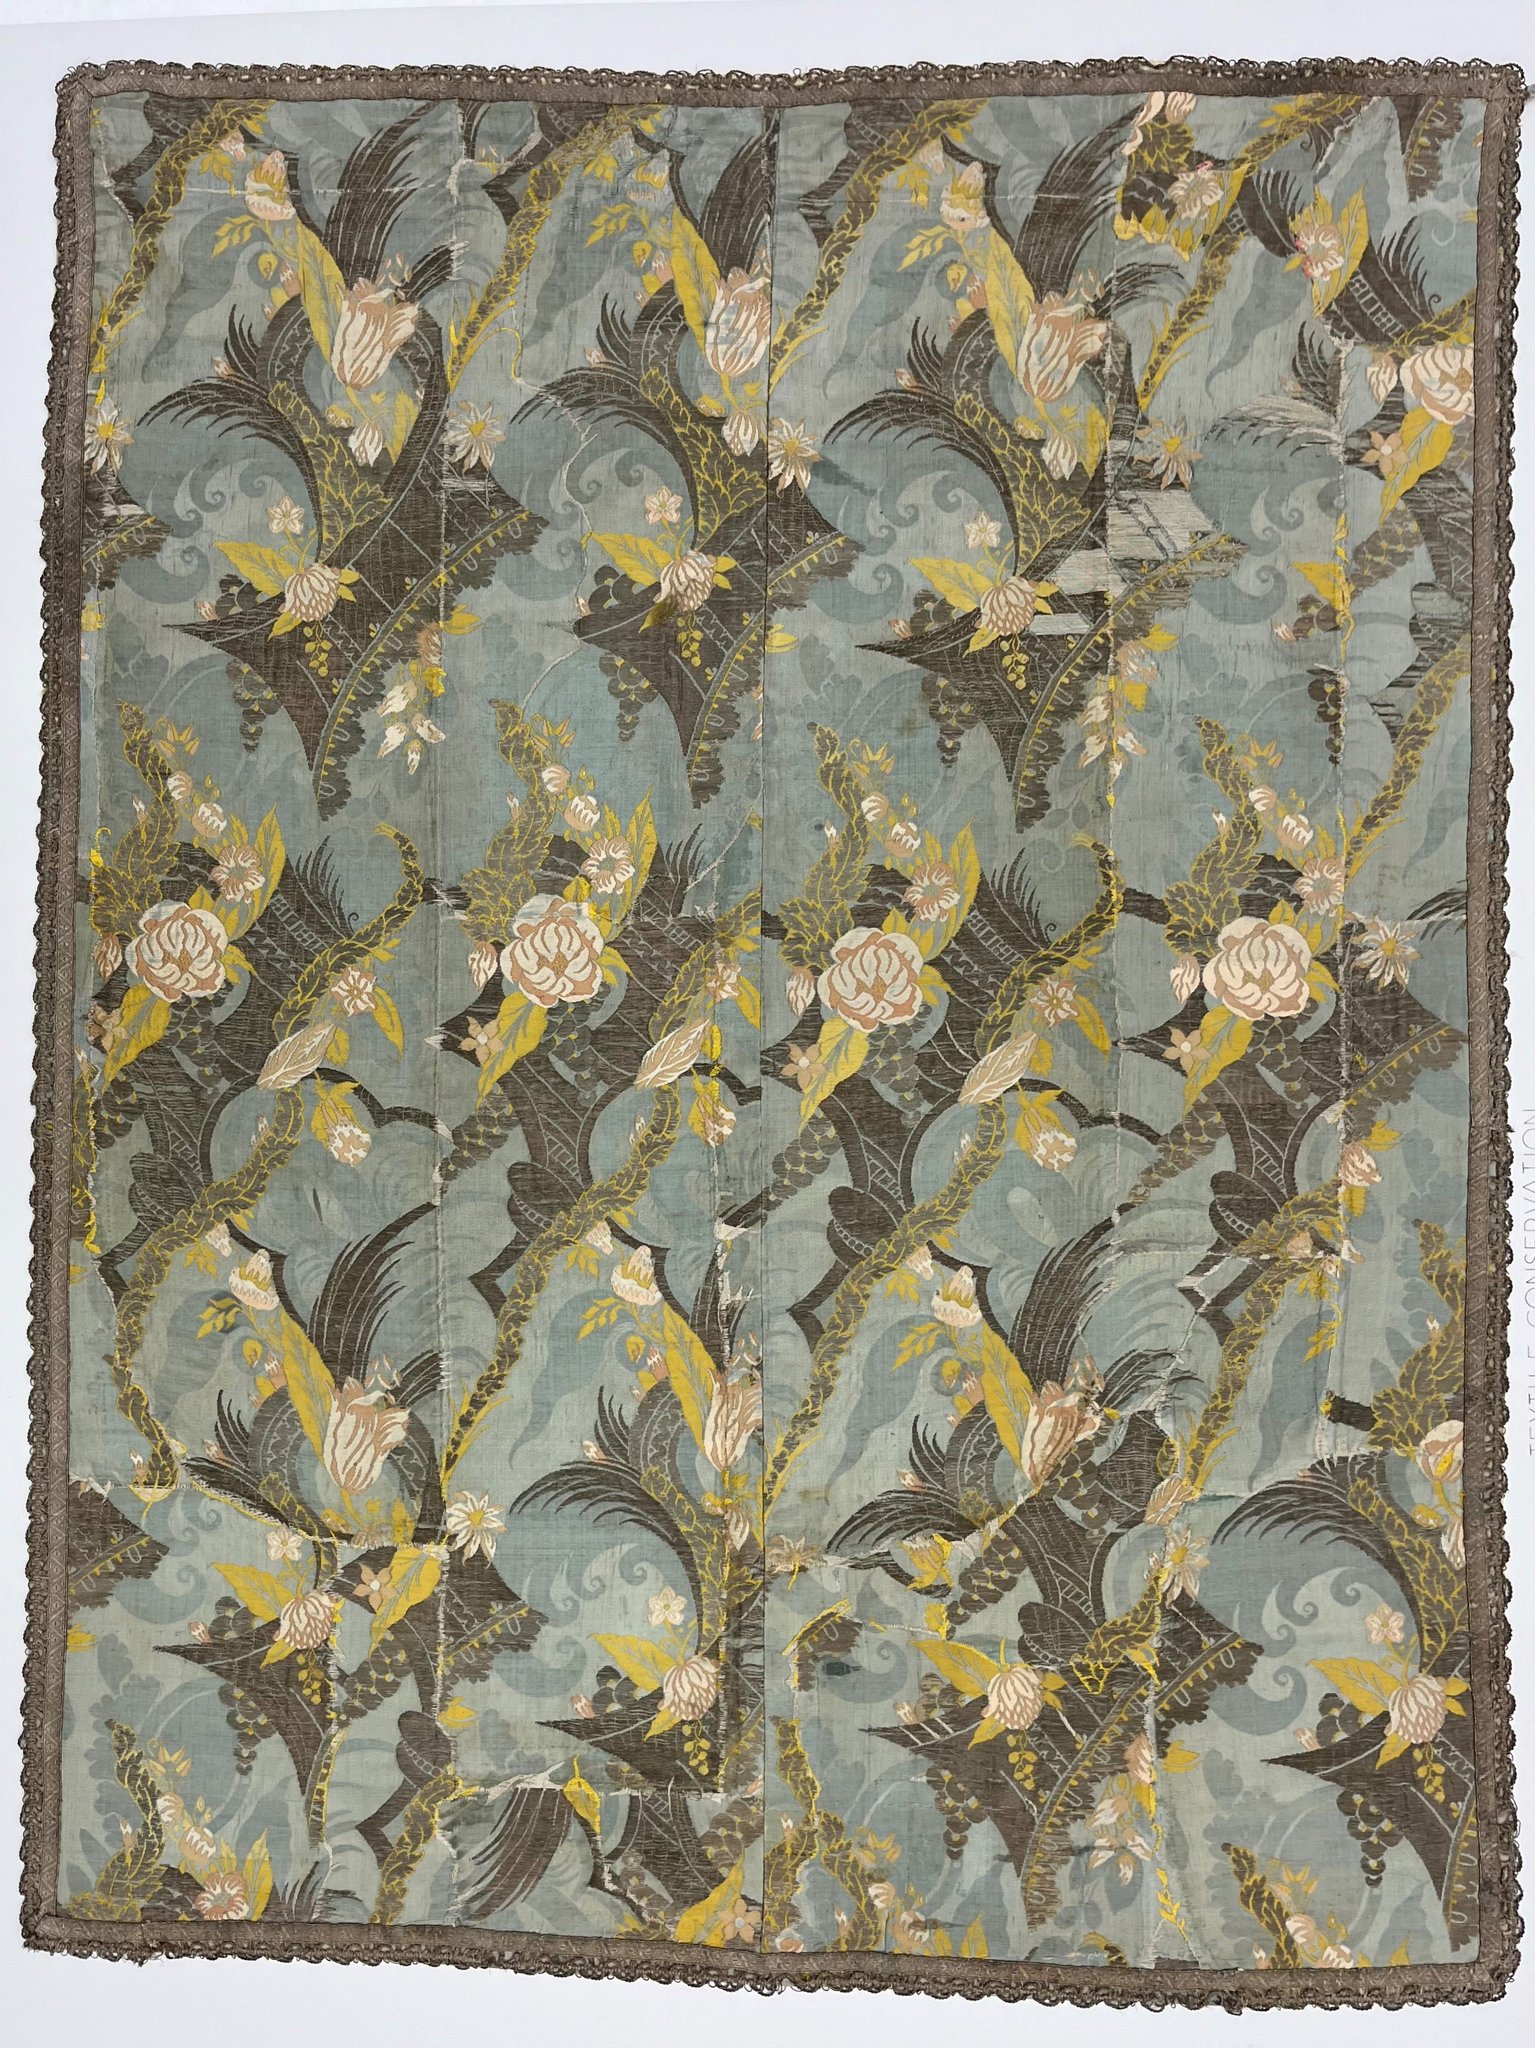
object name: piece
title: Length of Dress or Furnishing Fabric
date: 1705-1710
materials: metal thread, silk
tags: flowers